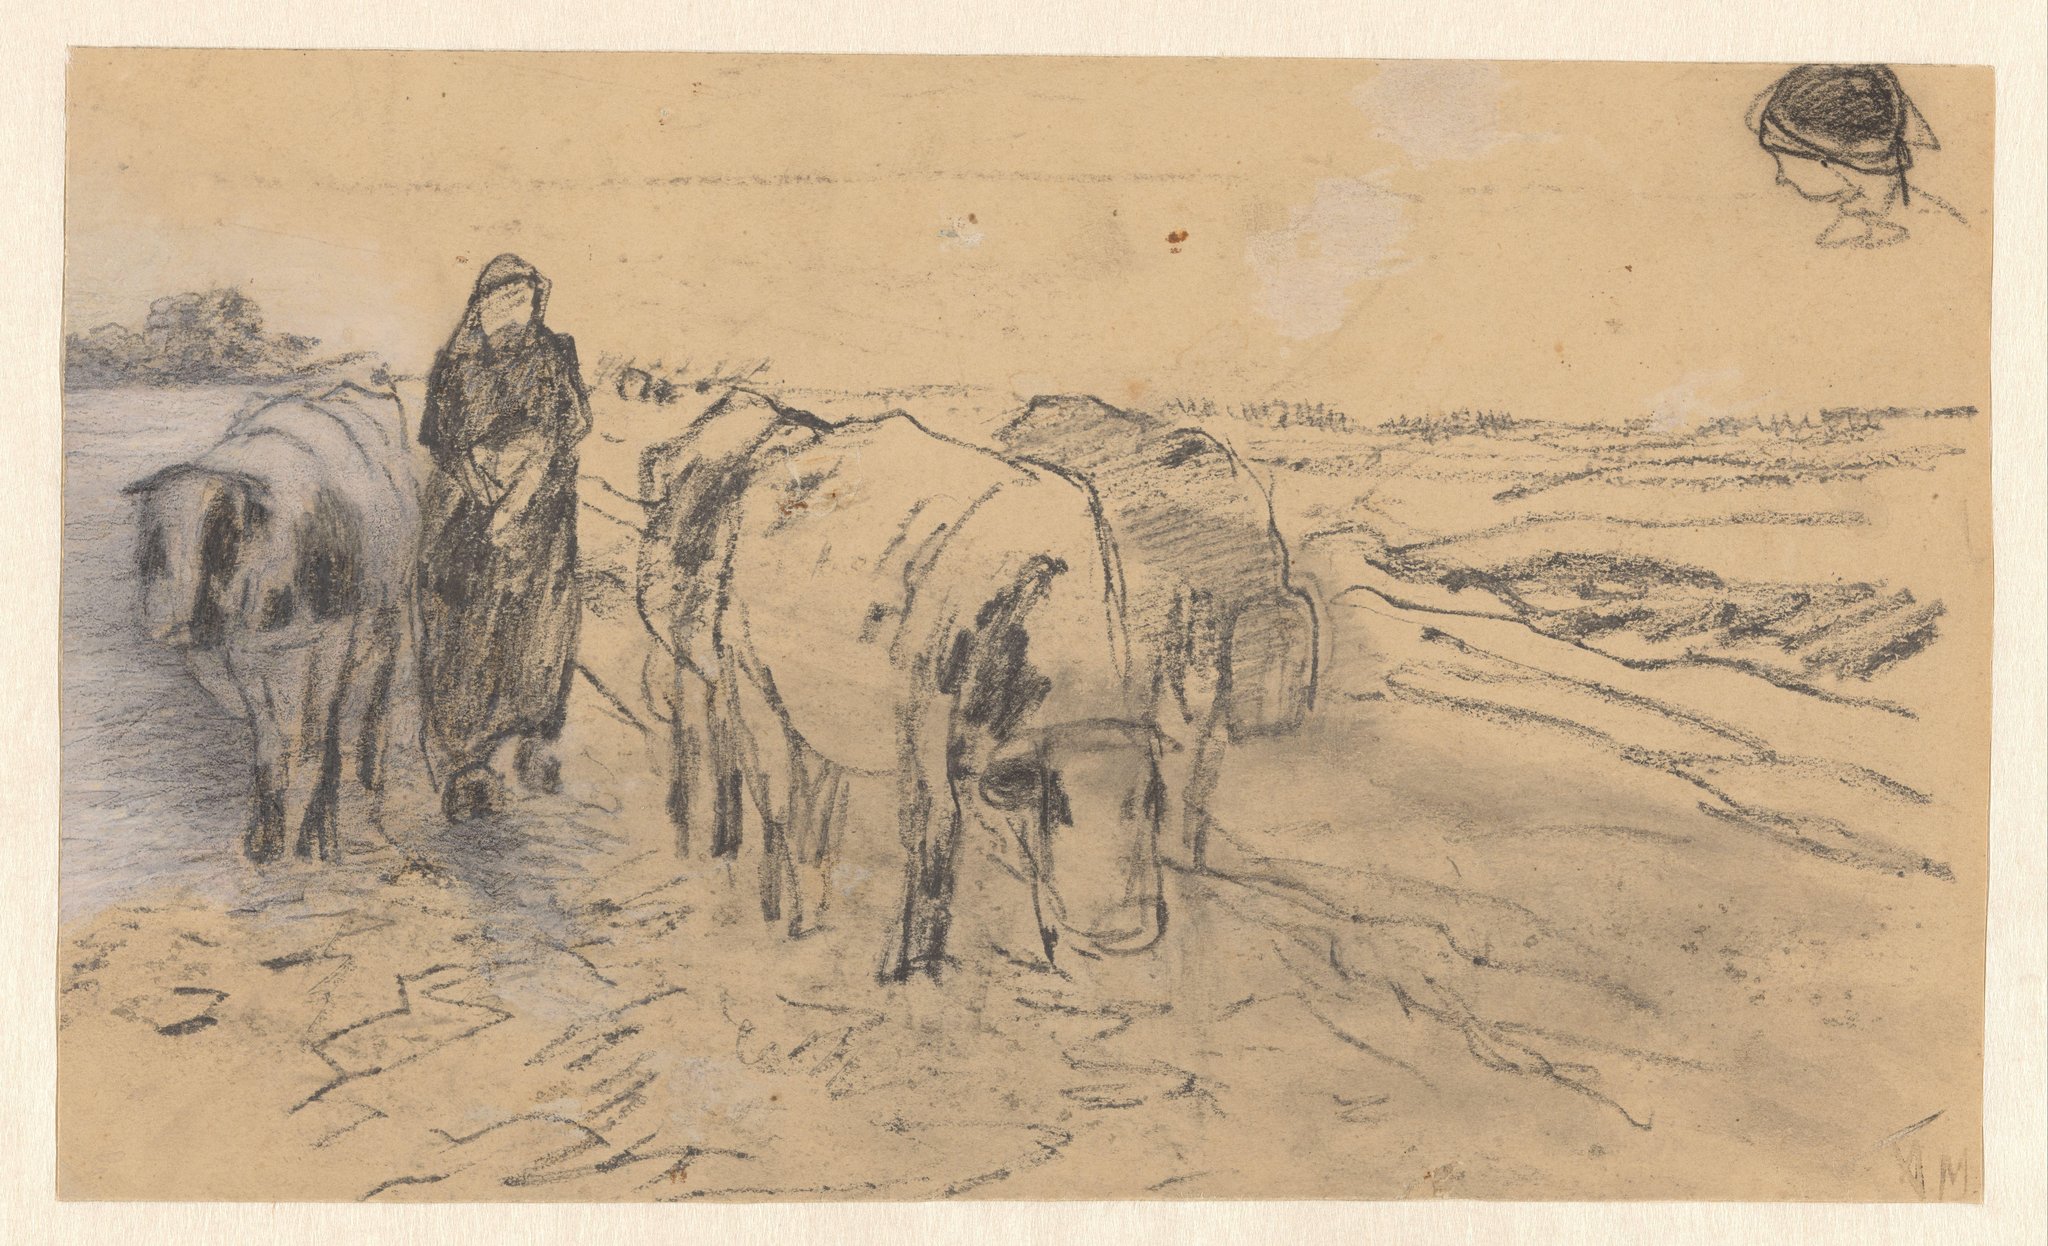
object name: drawing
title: Landschap met koeien en een herderin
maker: anton mauve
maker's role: draughtsman, painter, print maker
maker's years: 1838-1888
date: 1879-1884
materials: chalk, paper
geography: netherlands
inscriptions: workshop stamp: ‘A M’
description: Koeien en een herderin op een landweg in de regen. Rechtsboven een studie van een meisjeskopje